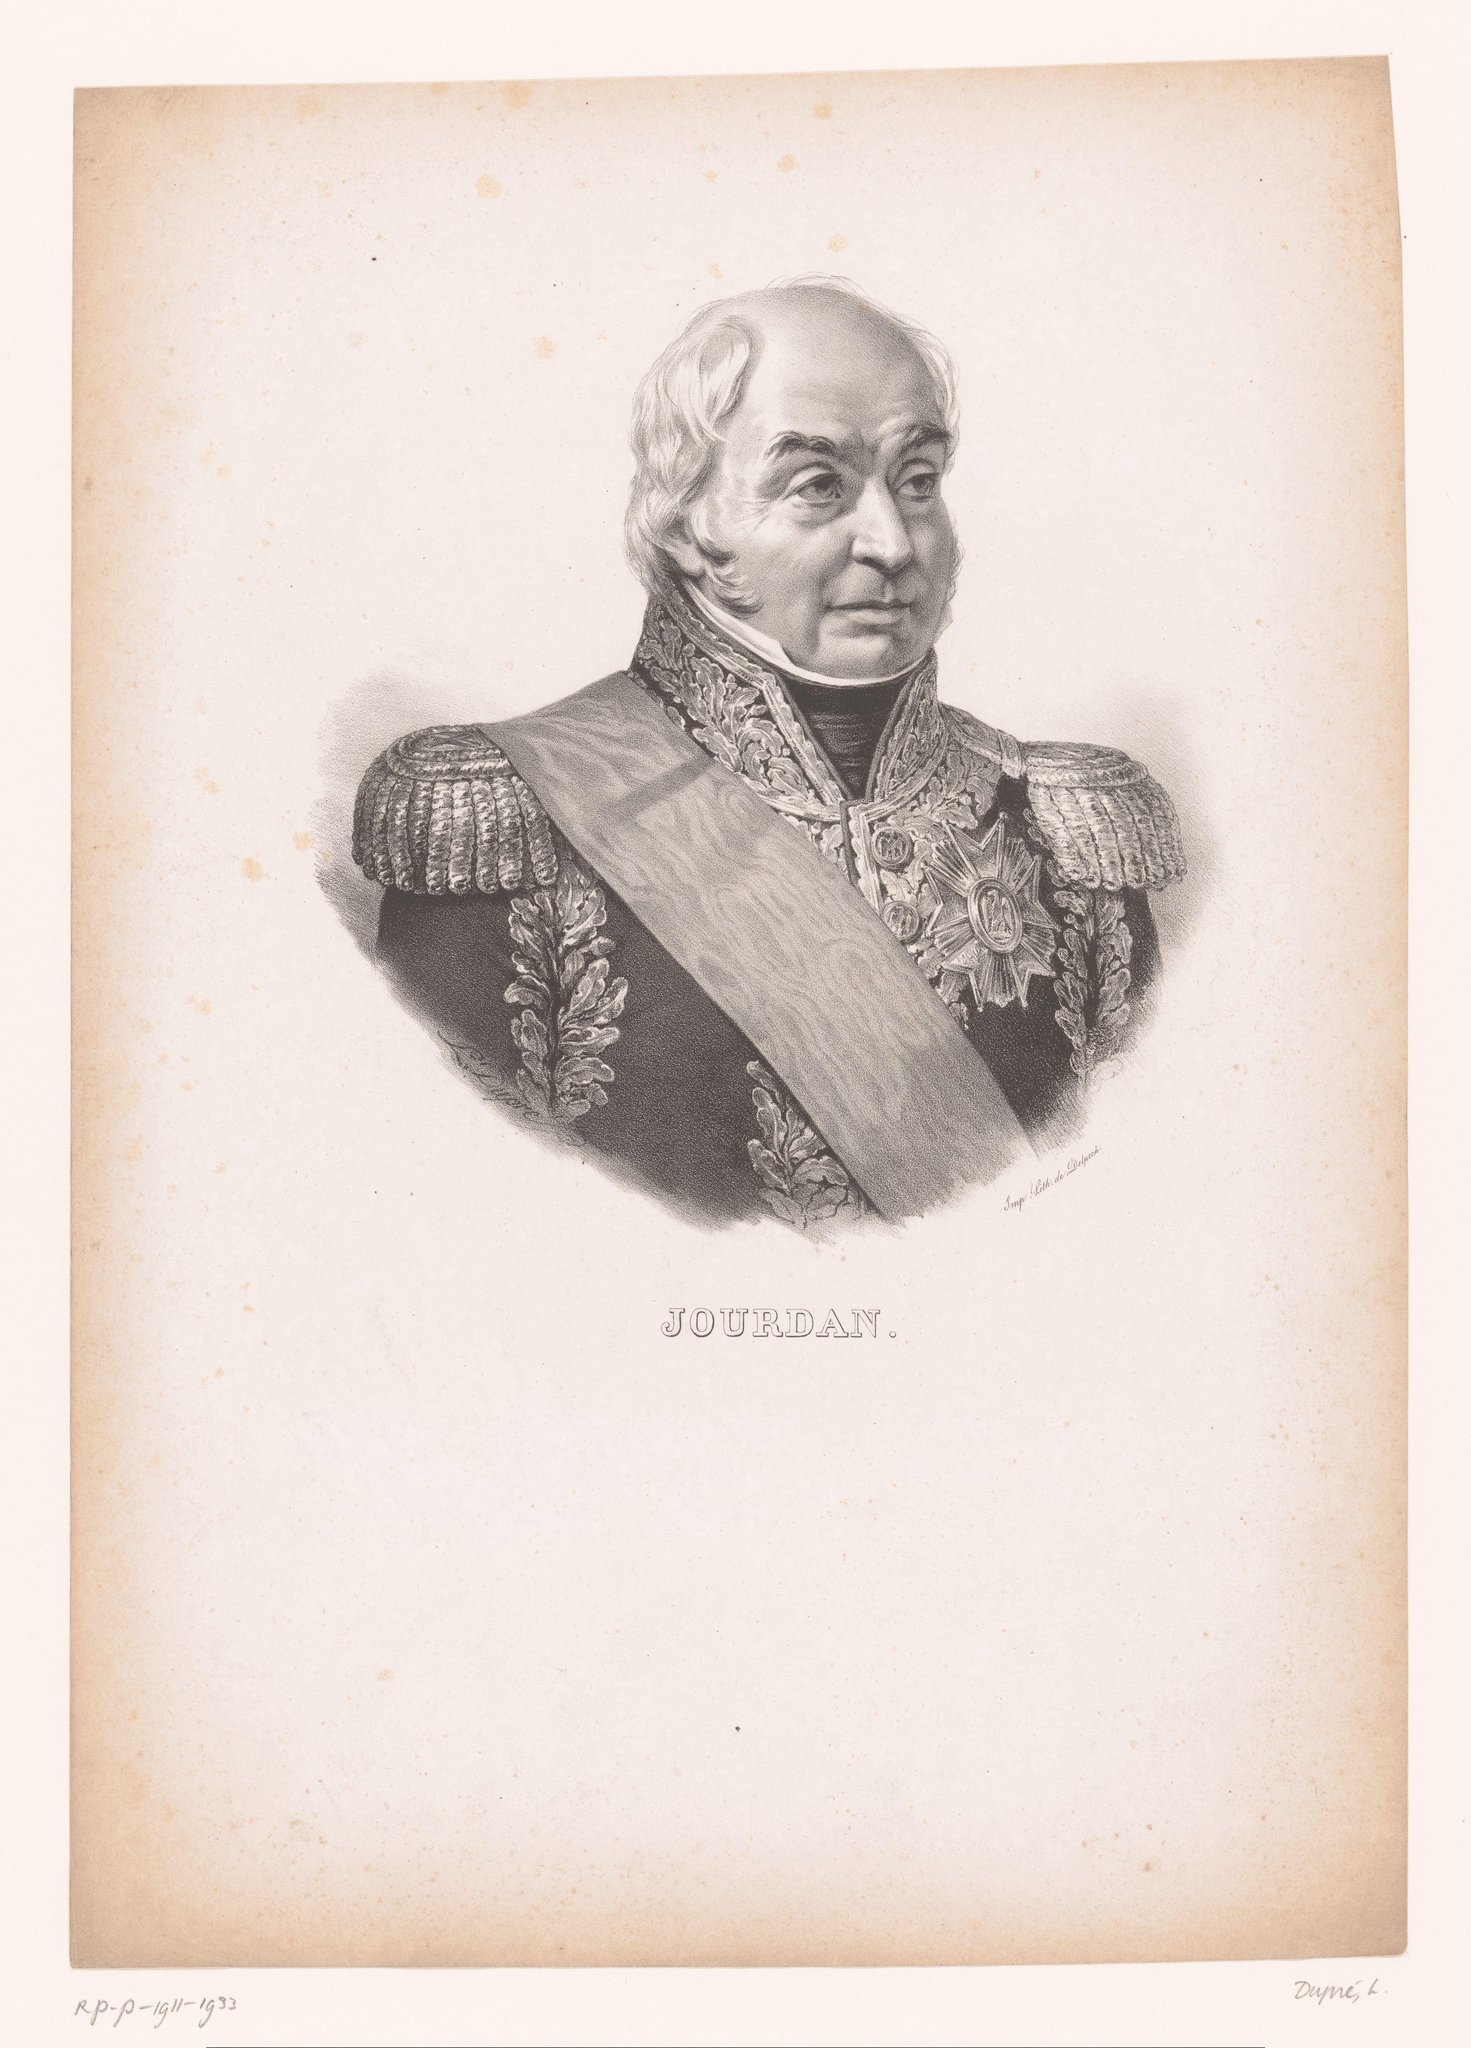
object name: print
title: Jourdan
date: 1832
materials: paper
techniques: lithograph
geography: paris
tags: paris, politician, historical persons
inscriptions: collector's mark: Lugt 2228a